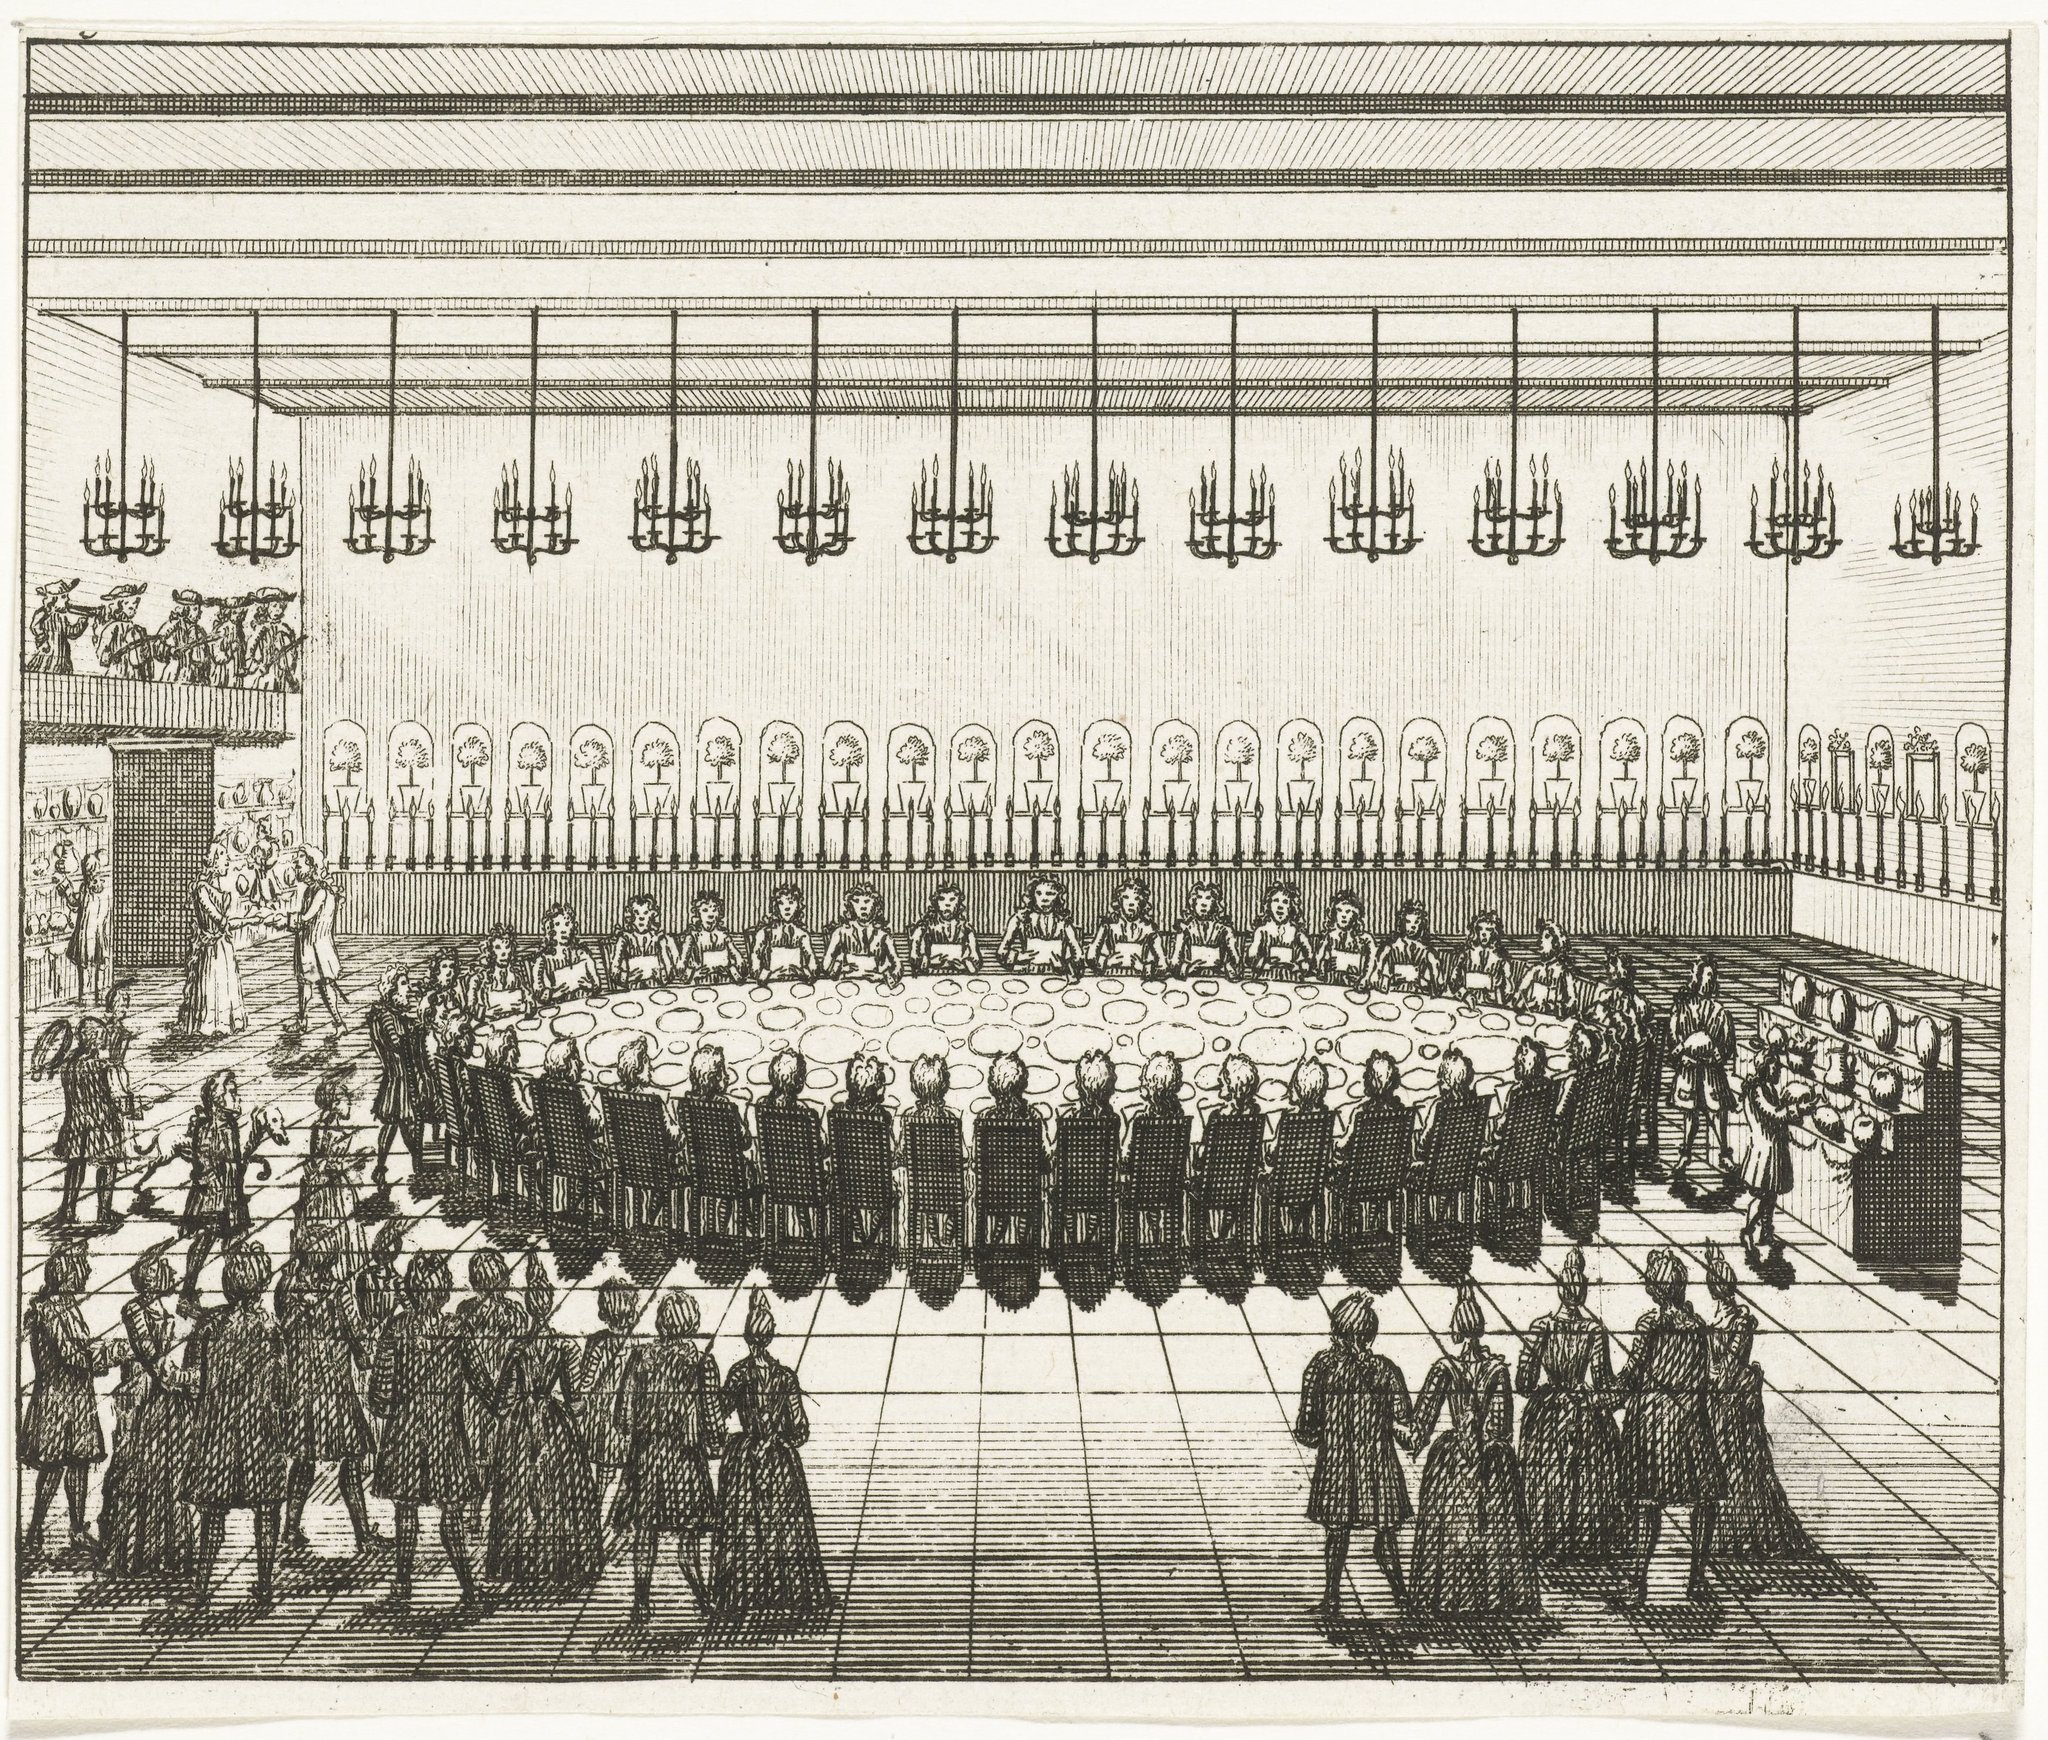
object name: print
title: Feestmaal in een zaal aan een ronde tafel, 1714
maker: Anonymous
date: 1714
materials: paper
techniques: etching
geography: northern netherlands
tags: public festivities at birth of royal persons, celebration meal, feast, banquet, utrecht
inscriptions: collector's mark: Lugt 2228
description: Feestmaal in een zaal aan een ronde tafel, 1714. Onderdeel van een groep van twaalf illustraties van de feestelijkheden georganiseerd in Utrecht in 1714 door de Portugese graaf Joao Gomes da Silva conde de Tarouca ter ere van de geboorte van twee Portugese prinsjes van koning Johan V.